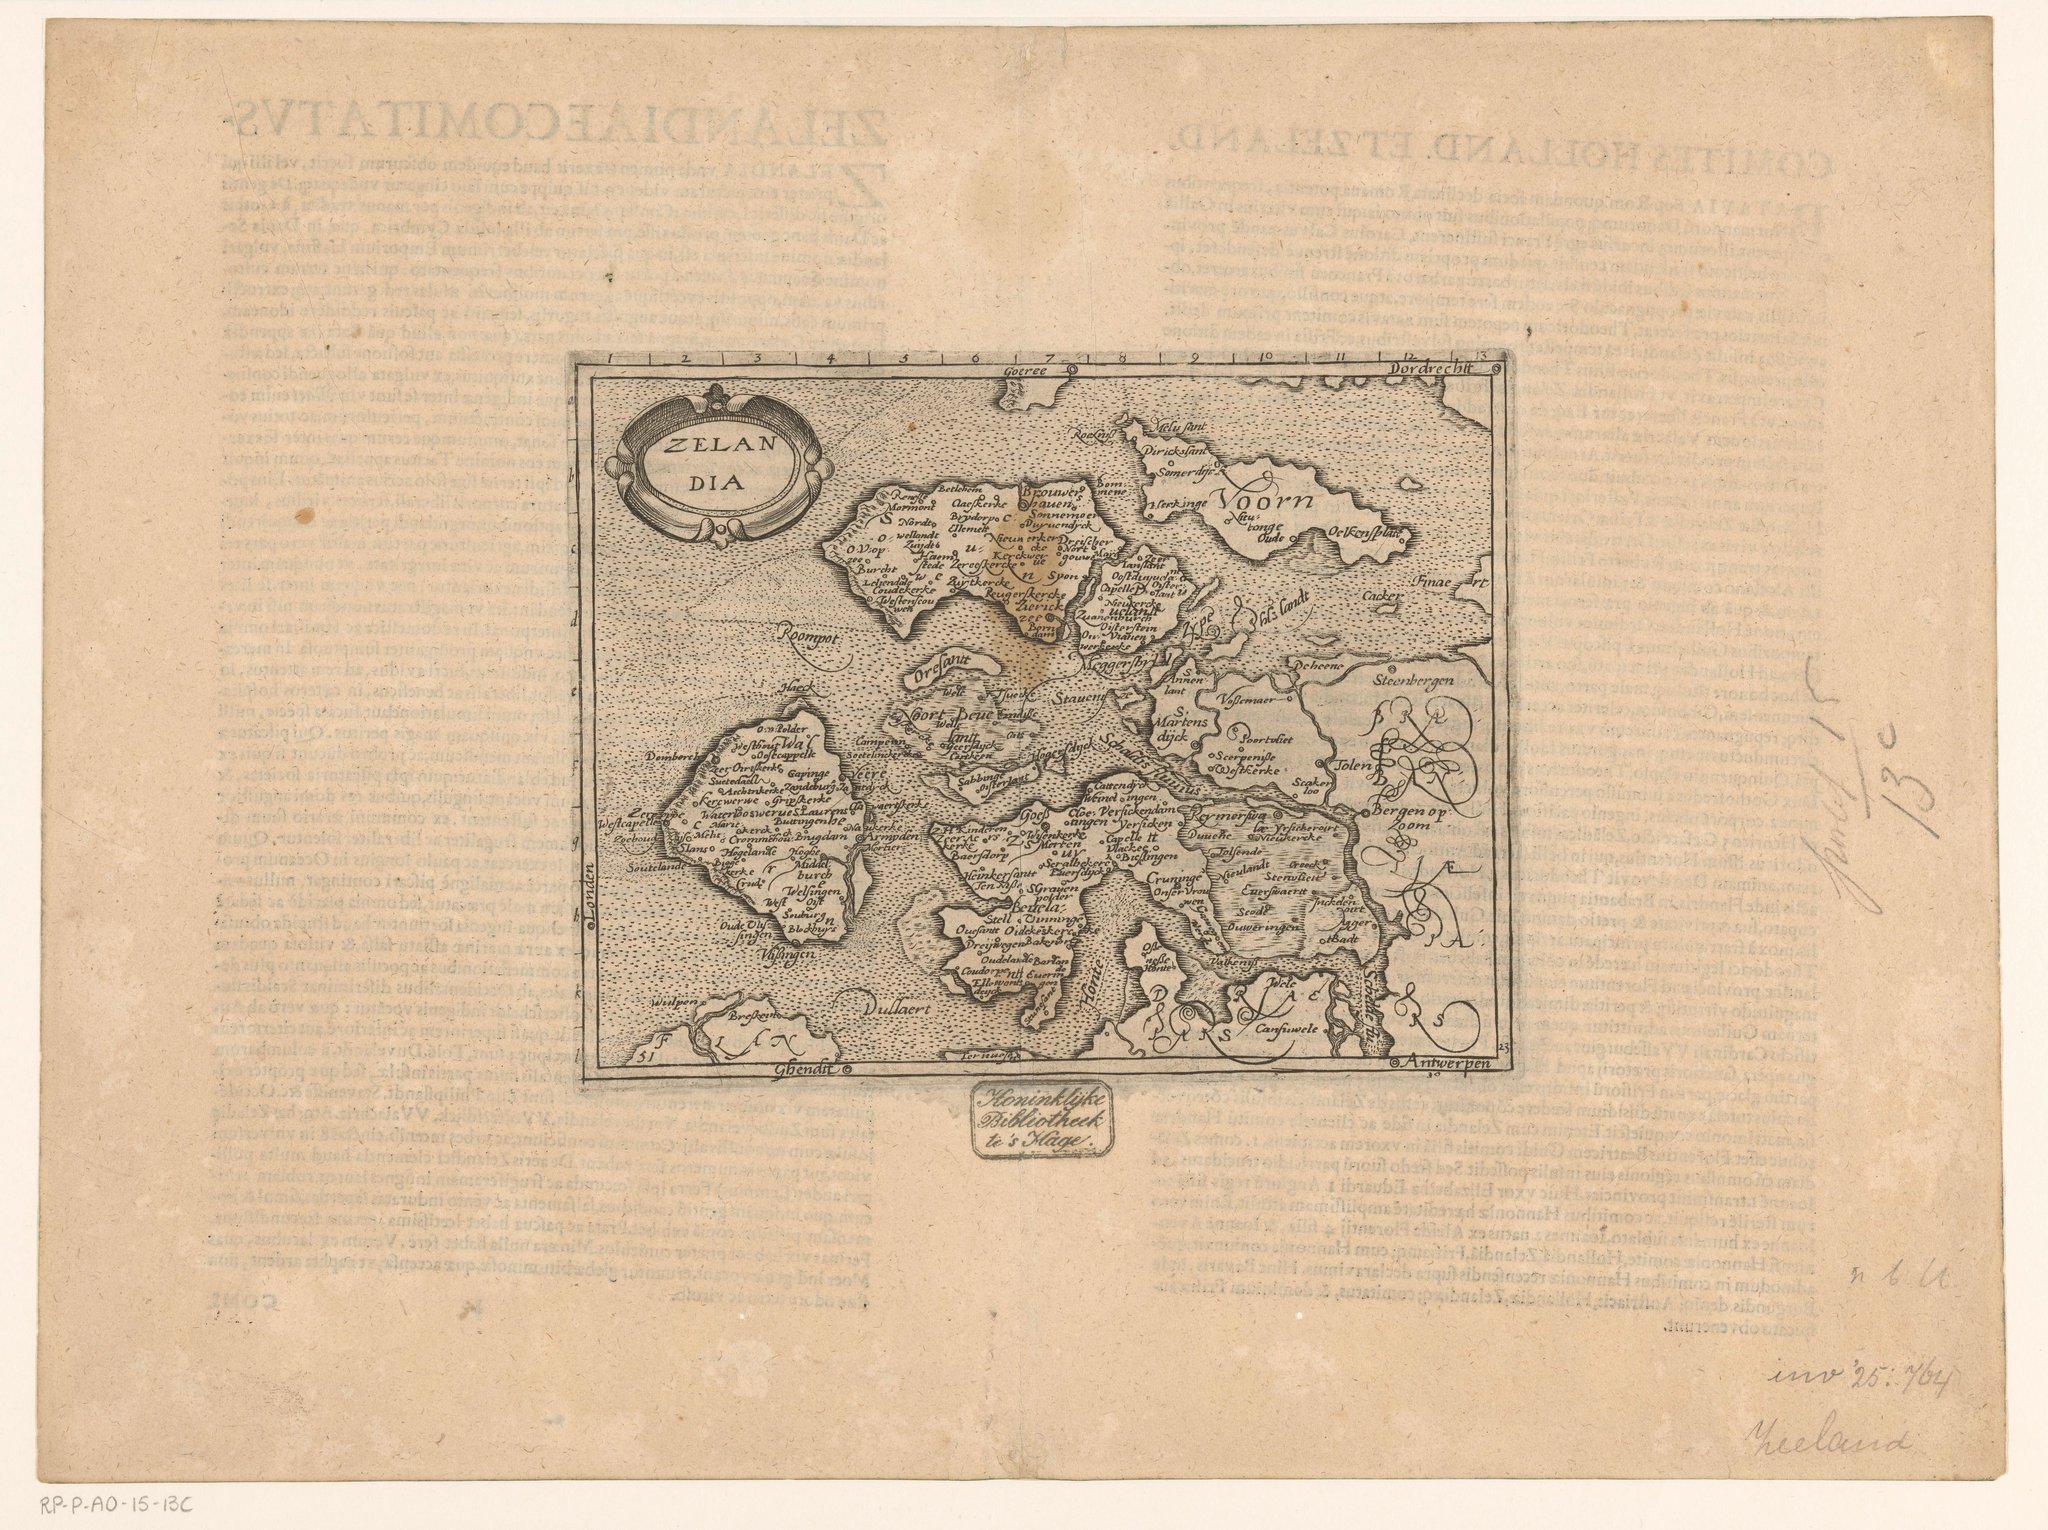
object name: map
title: Zelandia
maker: frans hogenberg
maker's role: print maker, publisher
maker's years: 1538-1590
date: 1579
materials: paper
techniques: engraving, letterpress printing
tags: maps of separate countries or regions, zeeland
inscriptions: collector's mark: Lugt 1098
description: Prent in een van de volgende drie publicaties gebruikt: - Matal, Johannes. Germania superior 38 inferior quae etiam Belgium dicitur 16 tabulis aeneis descripta (…). Keulen: Johannes Christophorus, 1598. - Matal, Johannes. Europa tabulis aeneis 166 secundum rationes geographicas delineata (…). Keulen: Johannes Christophorus, 1600. - Matal, Johannes. Speculum Orbis Terae (…). S.l.: Cornelus Sutorus [Cornelij Sutorij], 1602.